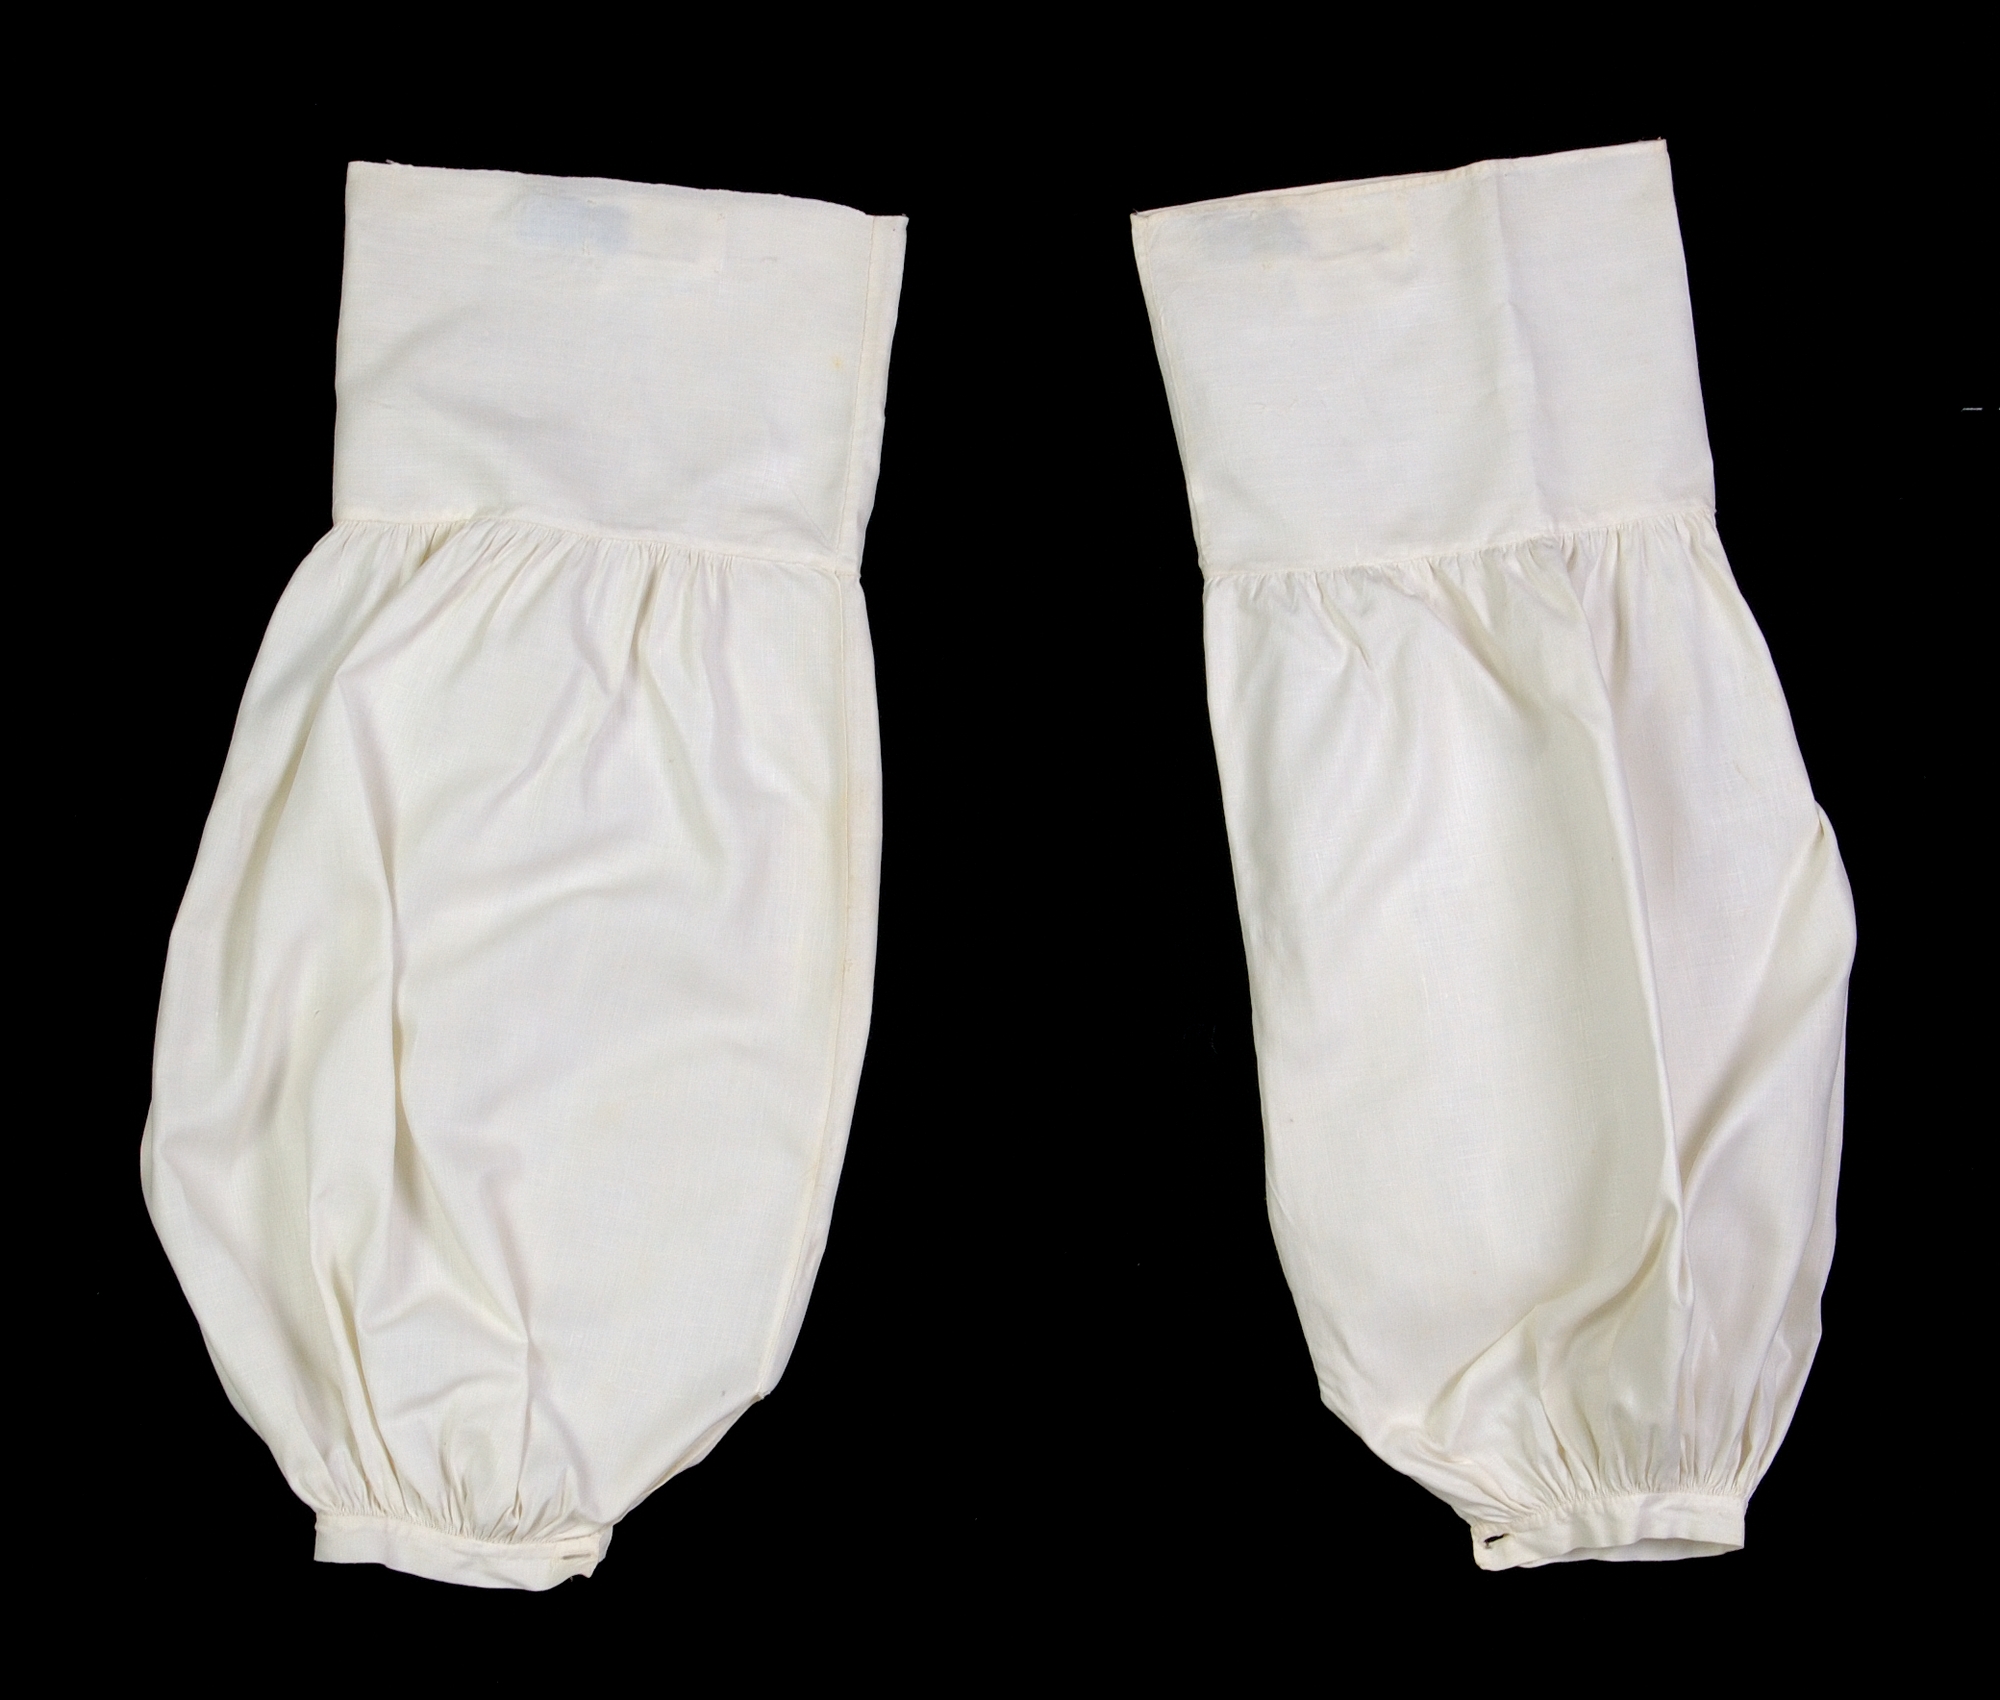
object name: undersleeves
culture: american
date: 1850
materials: linen